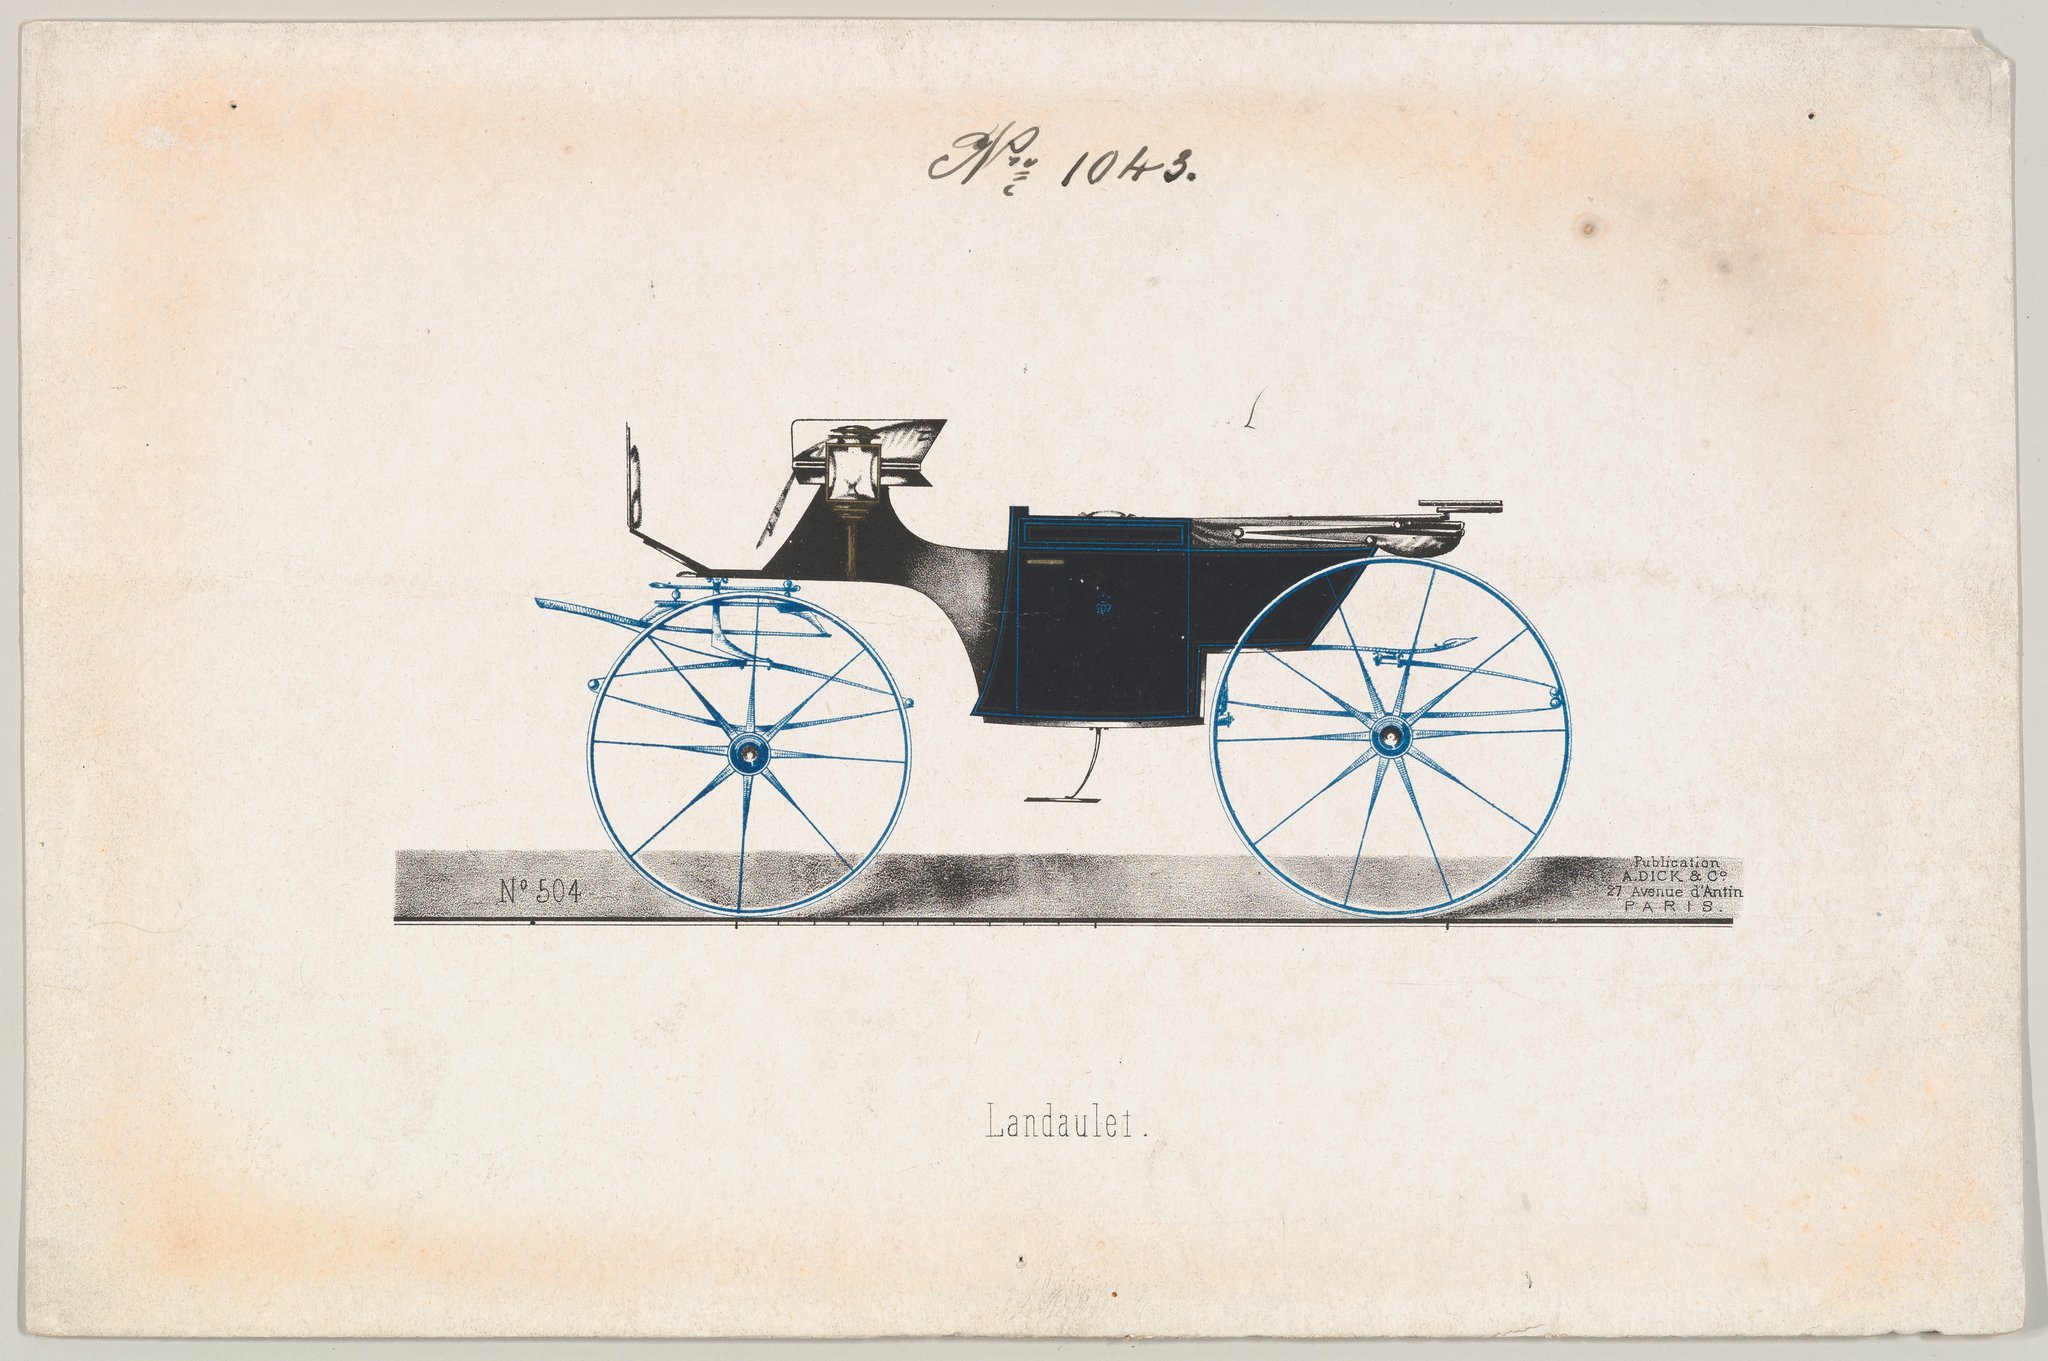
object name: drawing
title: Landaulet #1043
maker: brewster & co.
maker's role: manufacturer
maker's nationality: american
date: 1850-1870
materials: gouache, ink, watercolor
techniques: hand coloring, lithograph, pen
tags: carriages